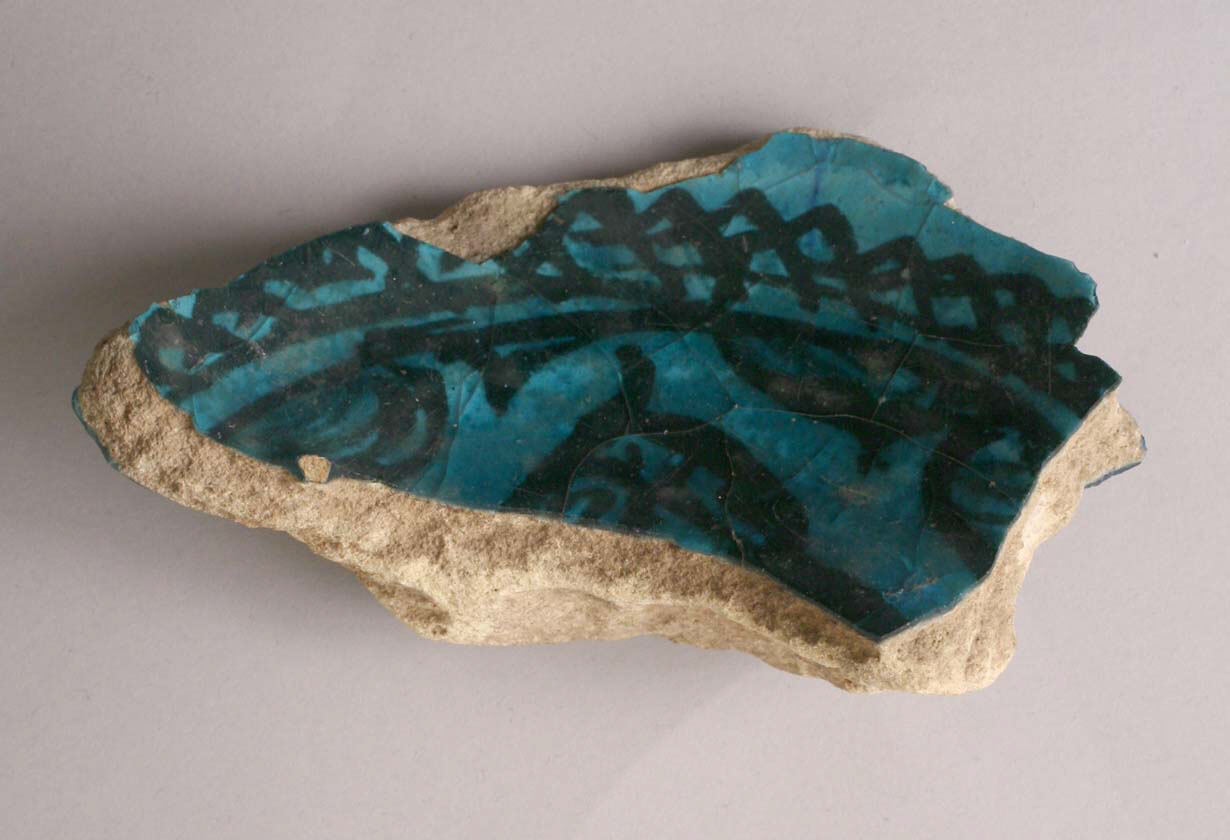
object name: fragment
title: Ceramic Fragment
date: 1301-1500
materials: glaze, stonepaste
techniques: painting, underglaze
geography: syria